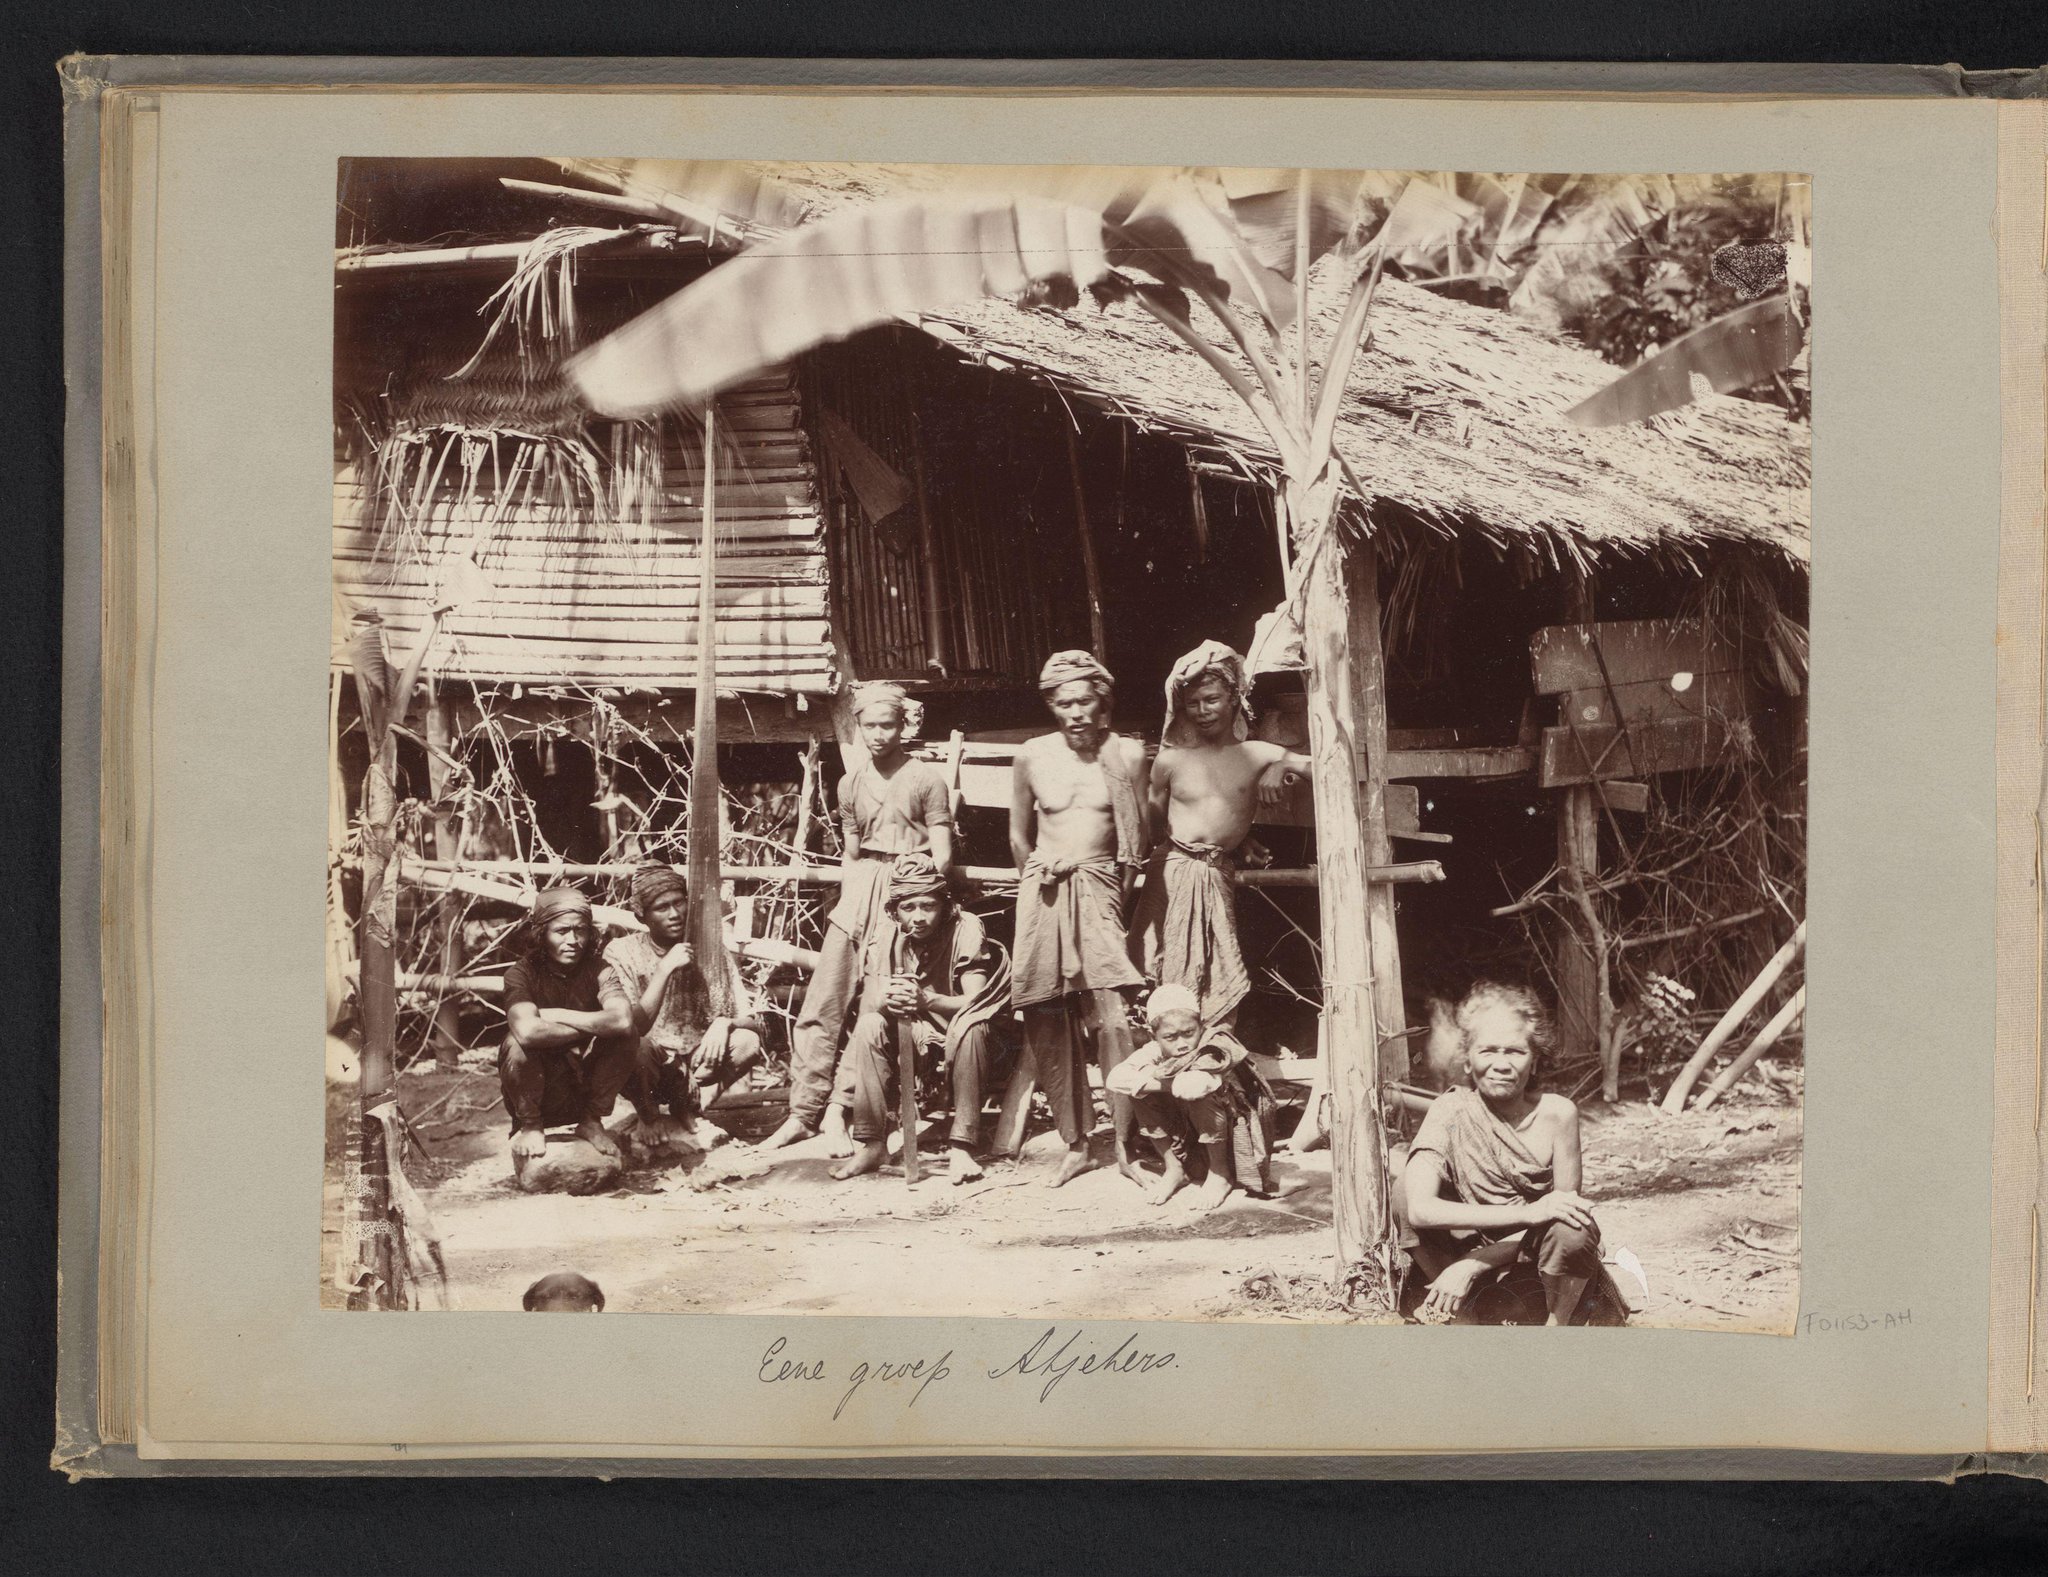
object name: photograph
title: Eene groep Atjehers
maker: Anonymous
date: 1891-1894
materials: photographic support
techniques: albumen print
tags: asiatic races and peoples (indonesians), historical persons, hearth and stove